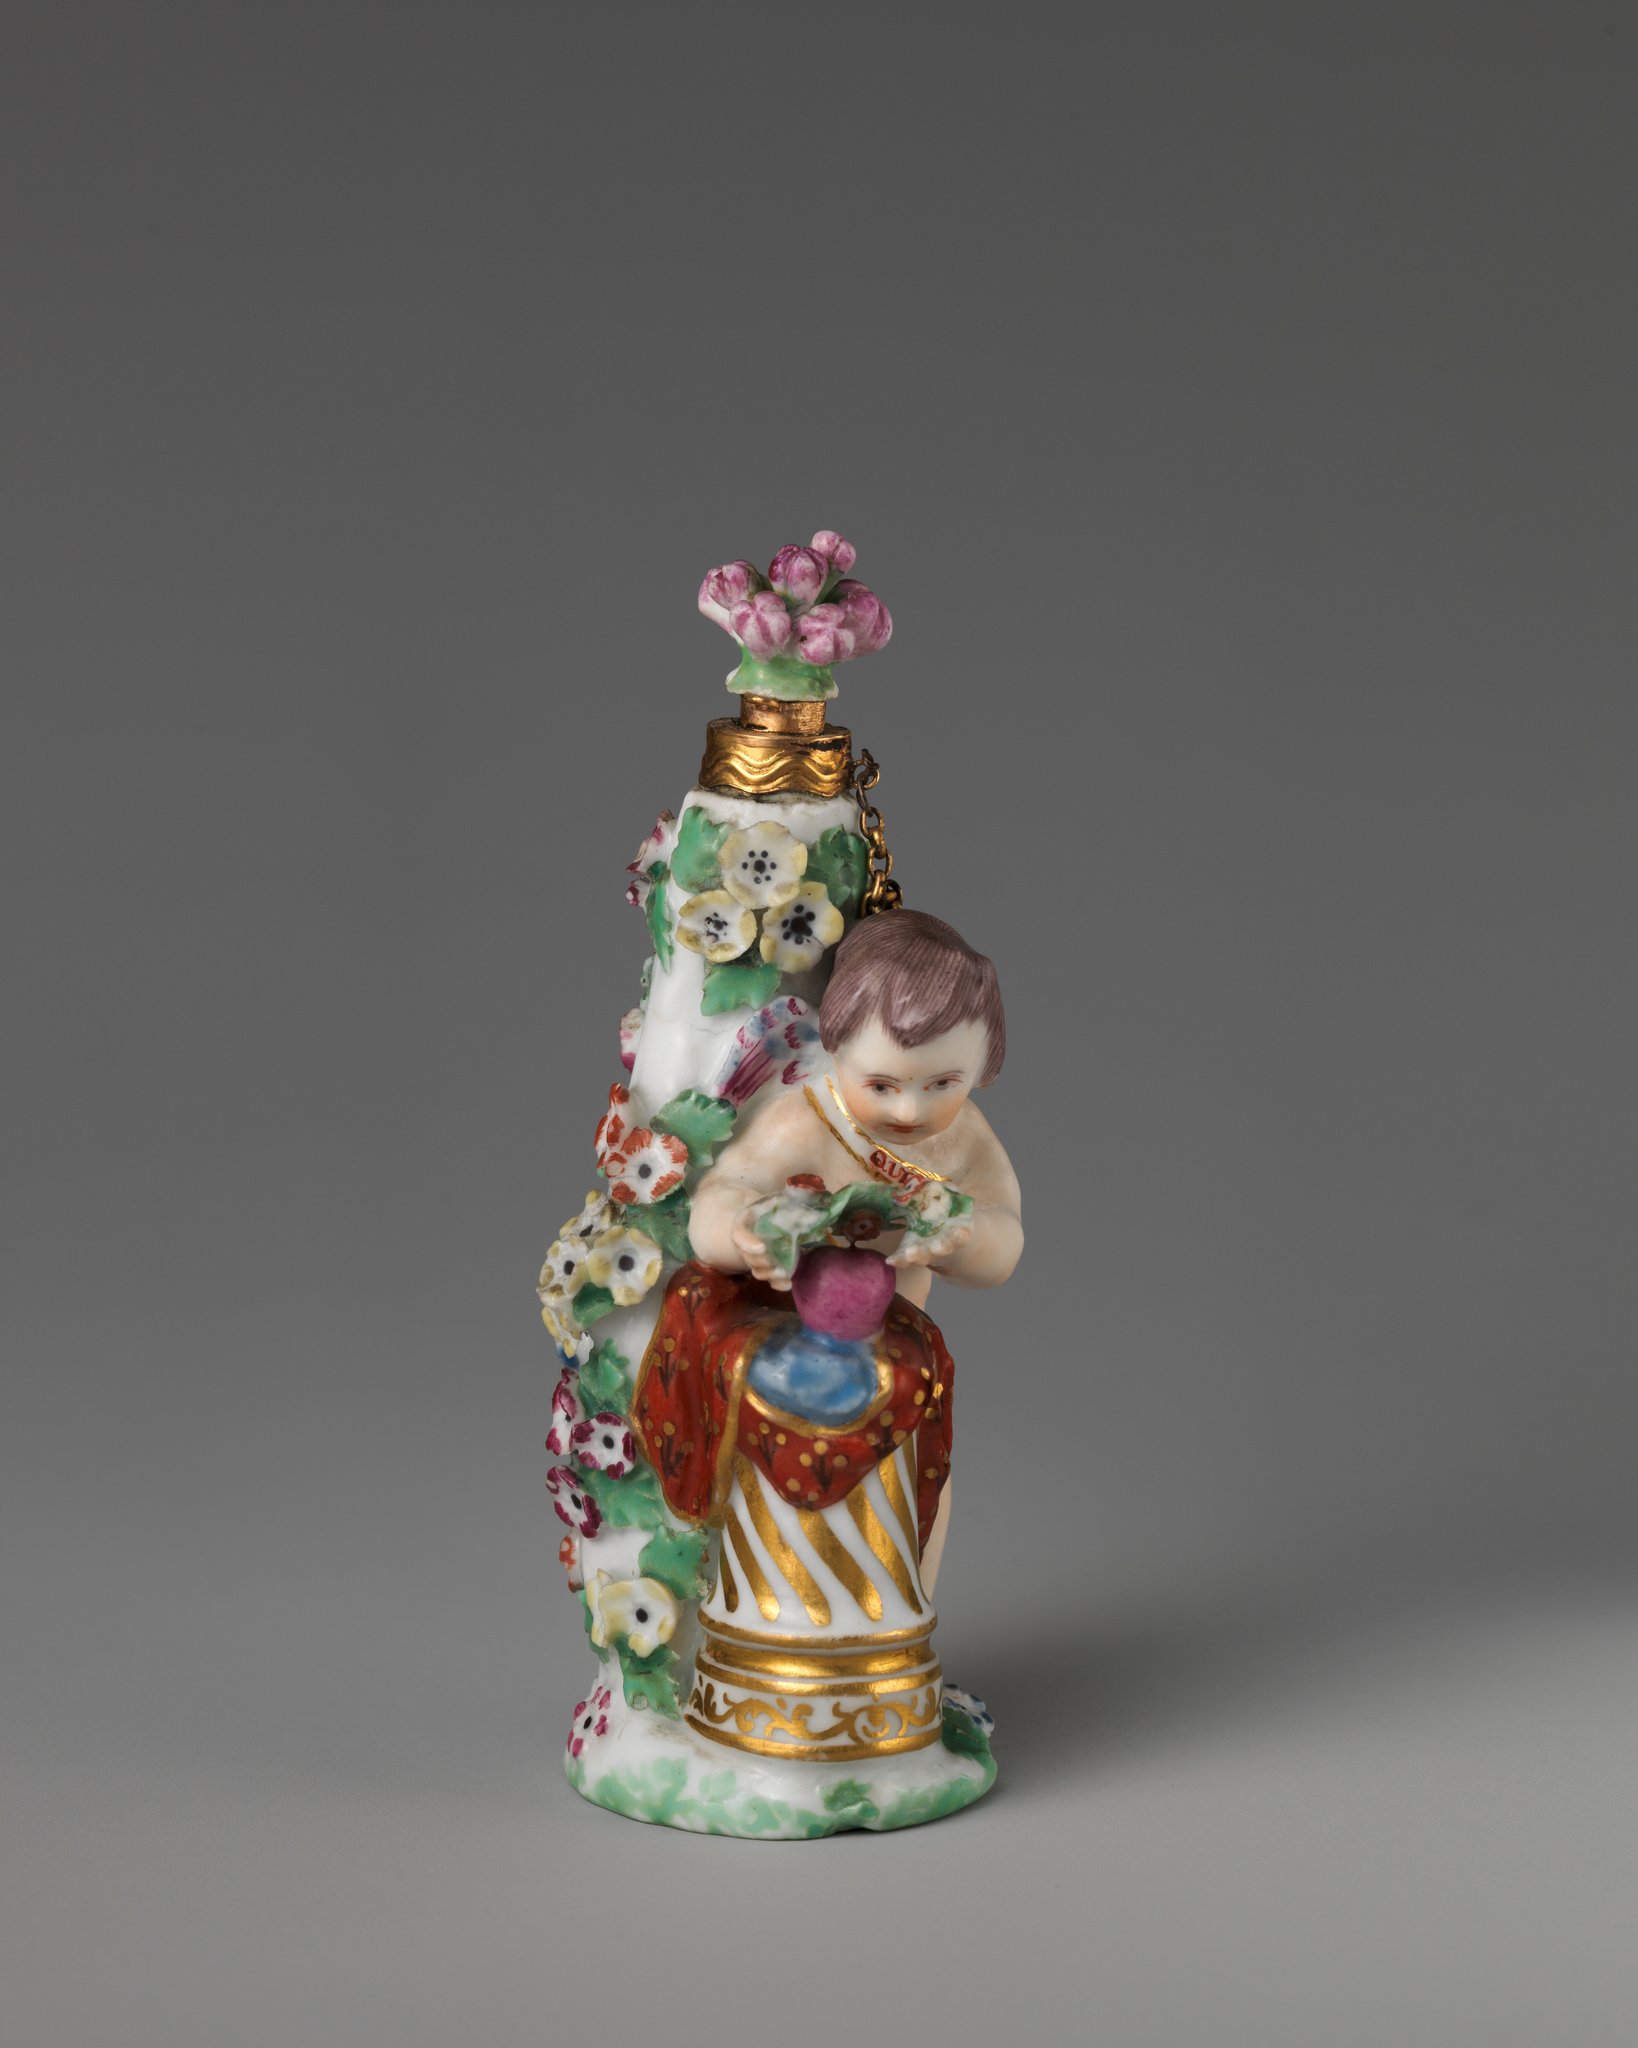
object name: toy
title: Cupid at the Altar of Love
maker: chelsea porcelain manufactory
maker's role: factory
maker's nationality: british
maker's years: 1744-1784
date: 1765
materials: soft paste porcelain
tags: cupid